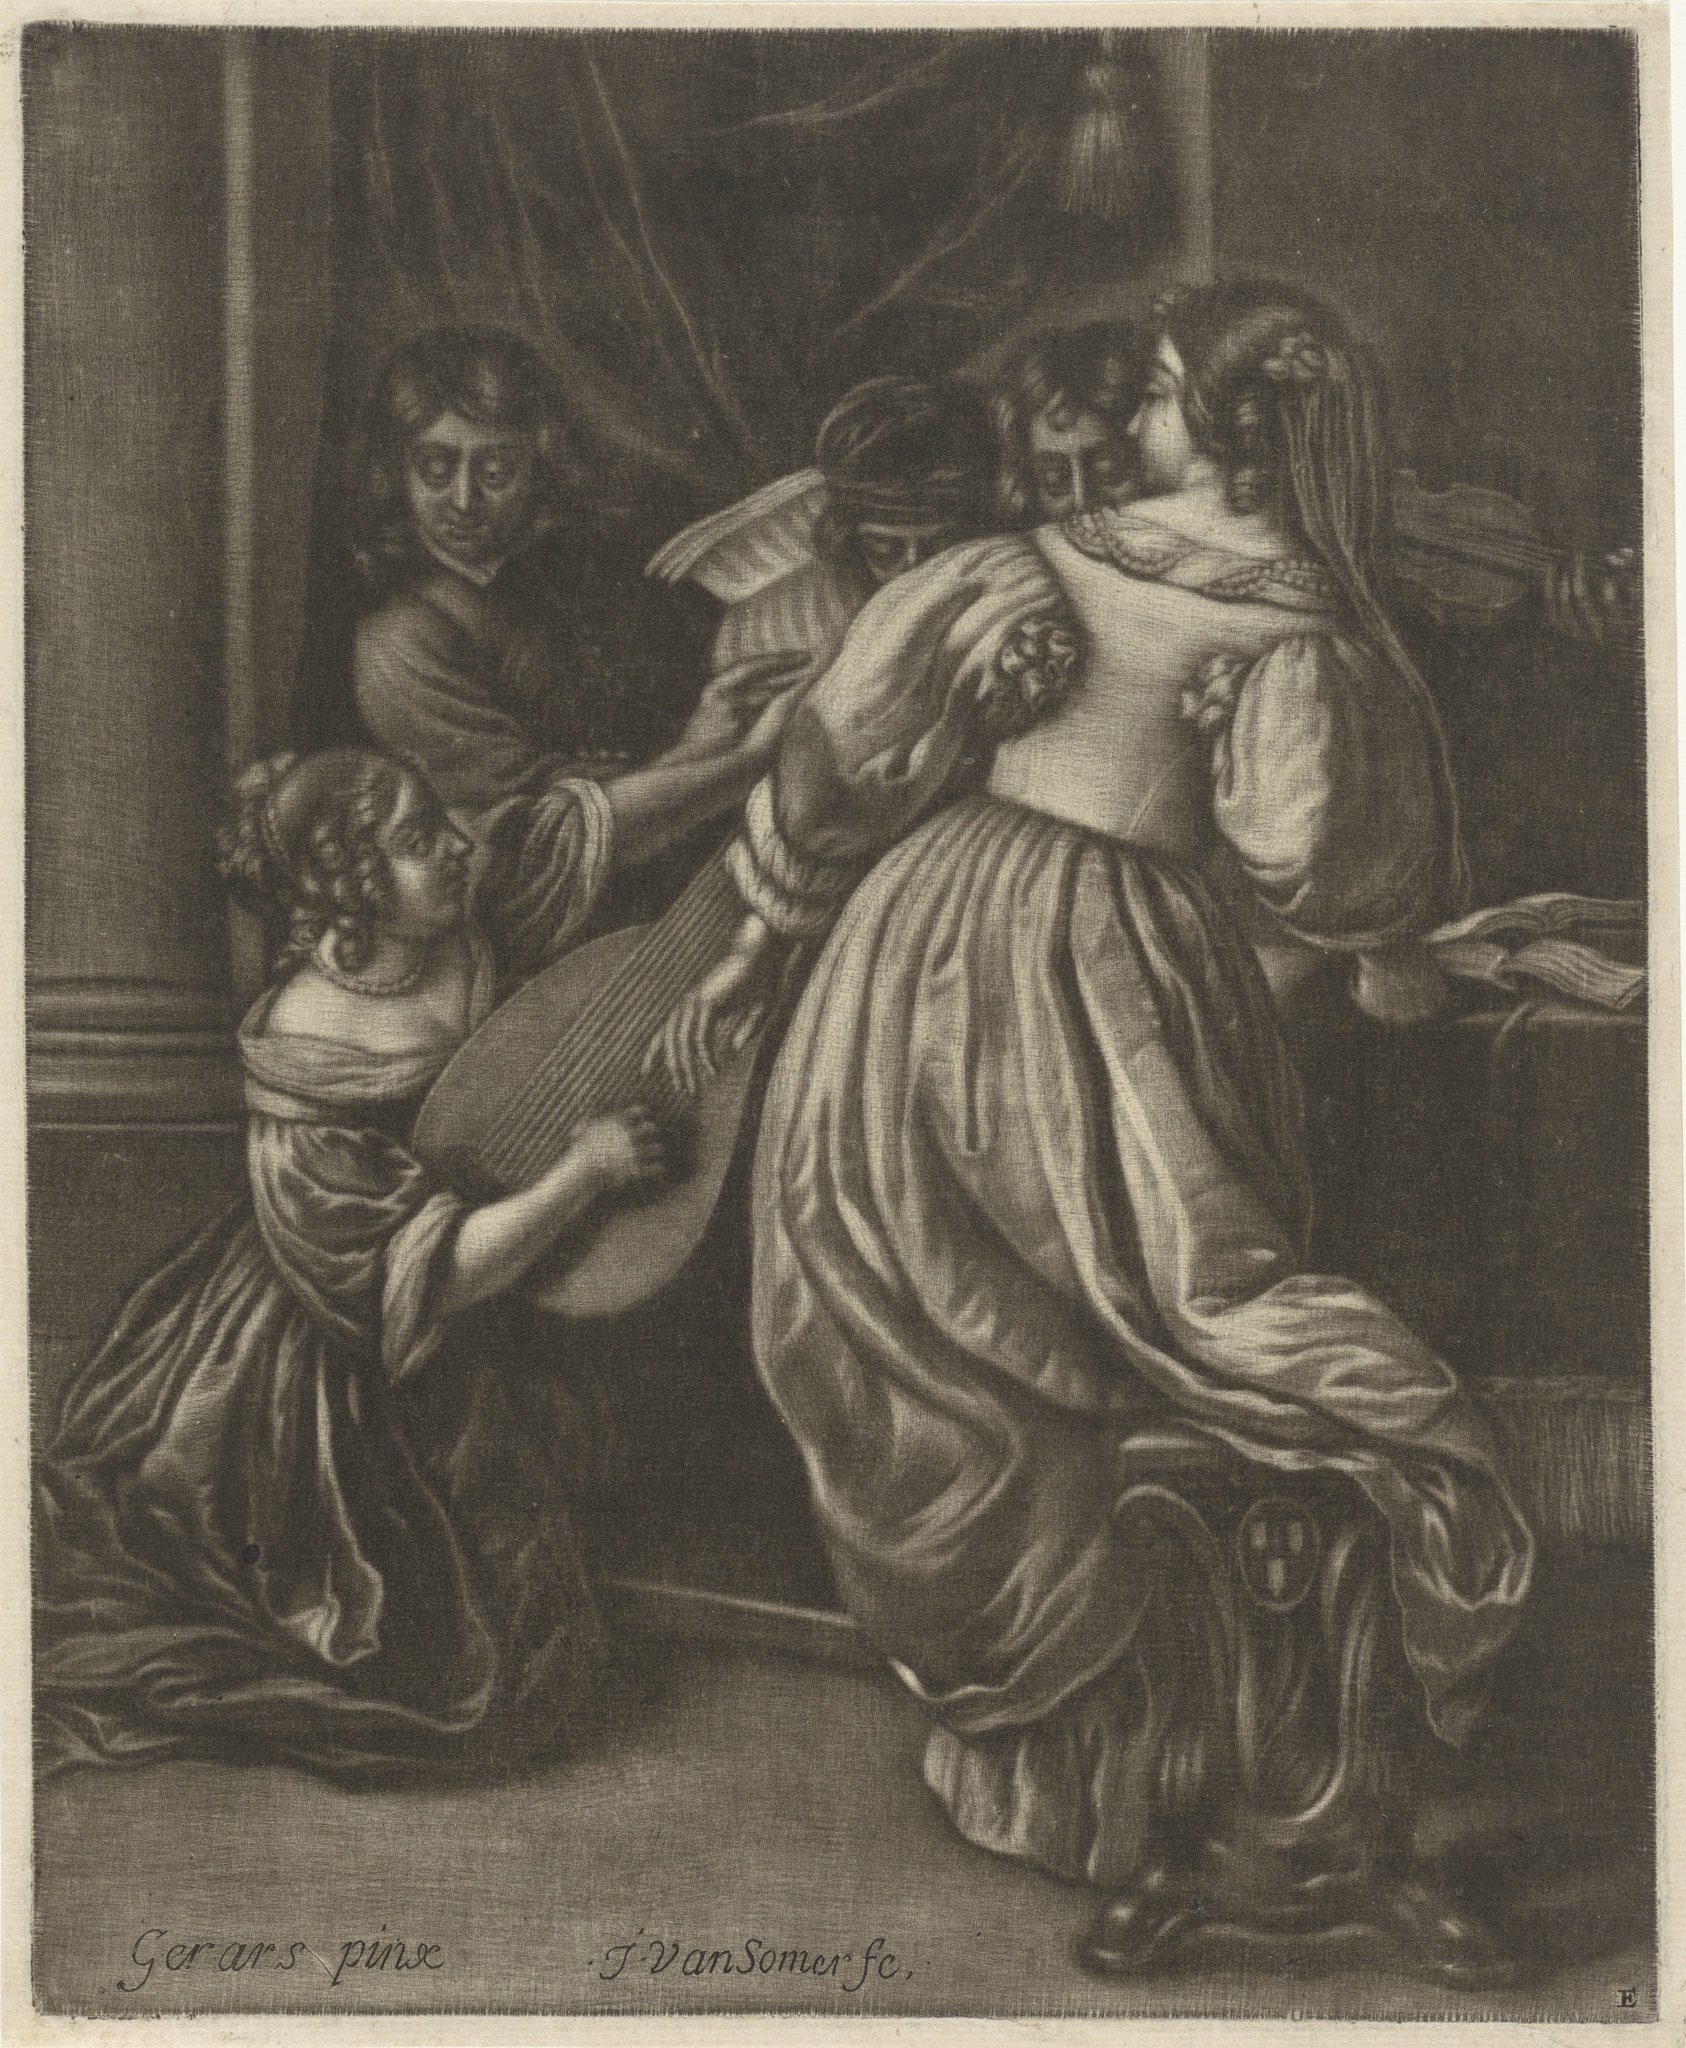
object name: print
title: Musicerend gezelschap rond een tafel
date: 1655-1700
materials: paper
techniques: mezzotint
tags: small group of musicians, chamber orchestra, jazz band, violin, fiddle, vocal music, singing, printed edition of musical score, lute, and special forms of lute, e.g.: theorbo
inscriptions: collector's mark: Lugt 2228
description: Rond een tafel musiceert een gezelschap van vijf personen. Er wordt gezongen, viool en luit gespeeld. Op tafel boekjes met bladmuziek.